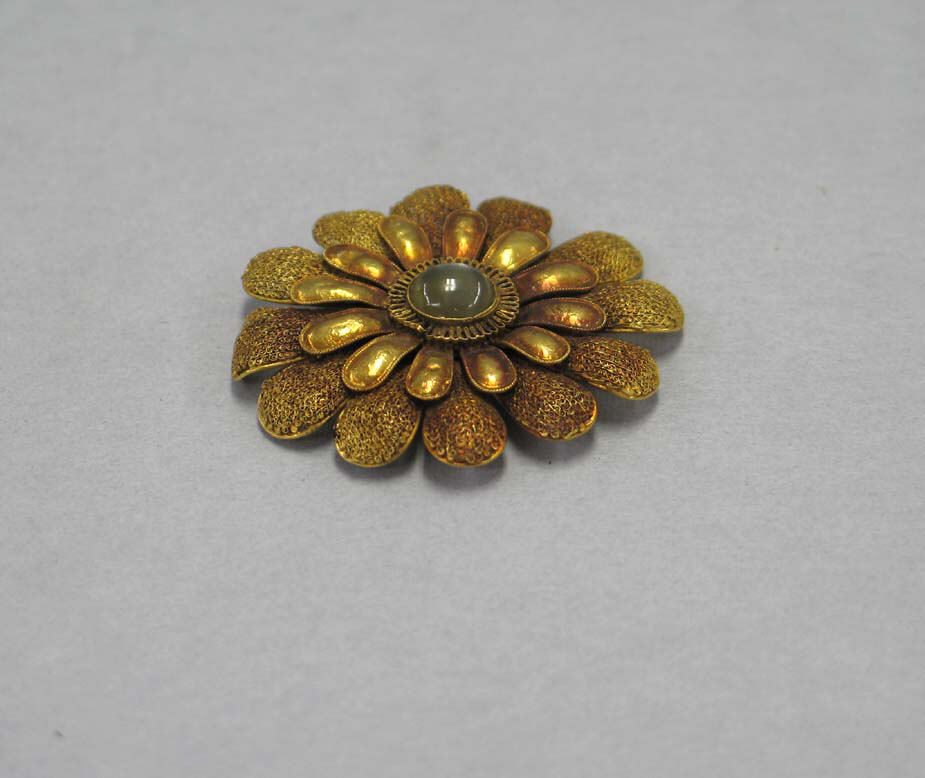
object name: ornament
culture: chinese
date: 960-1279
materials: gold